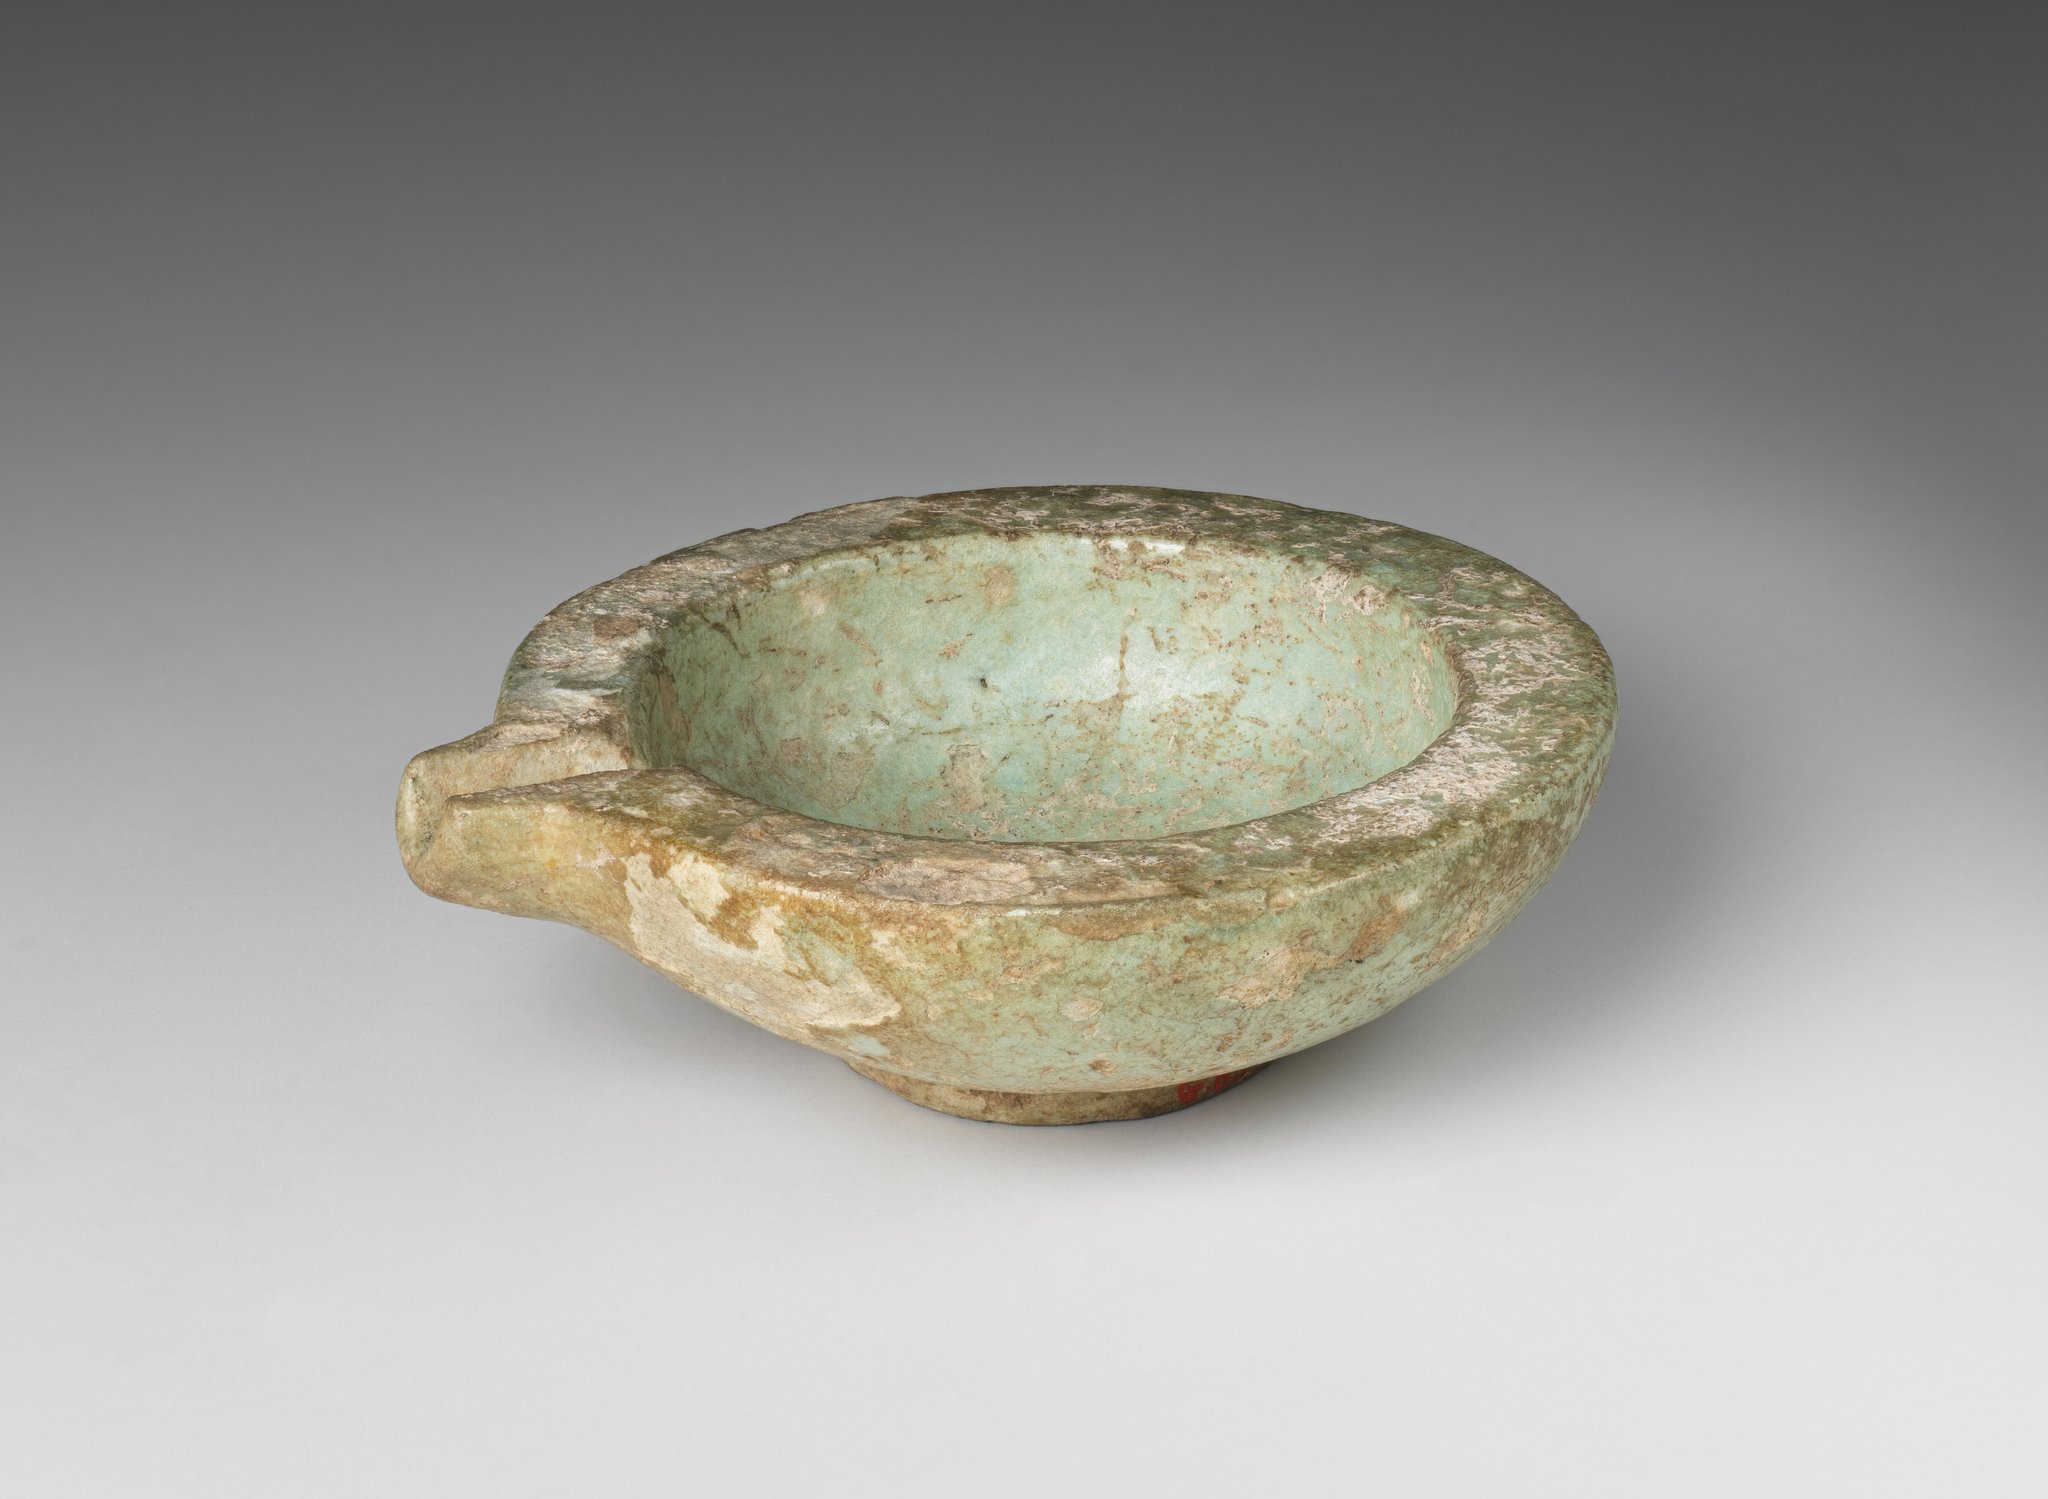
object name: dish saucer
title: Spouted dish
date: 664-332 BCE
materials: faience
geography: egypt